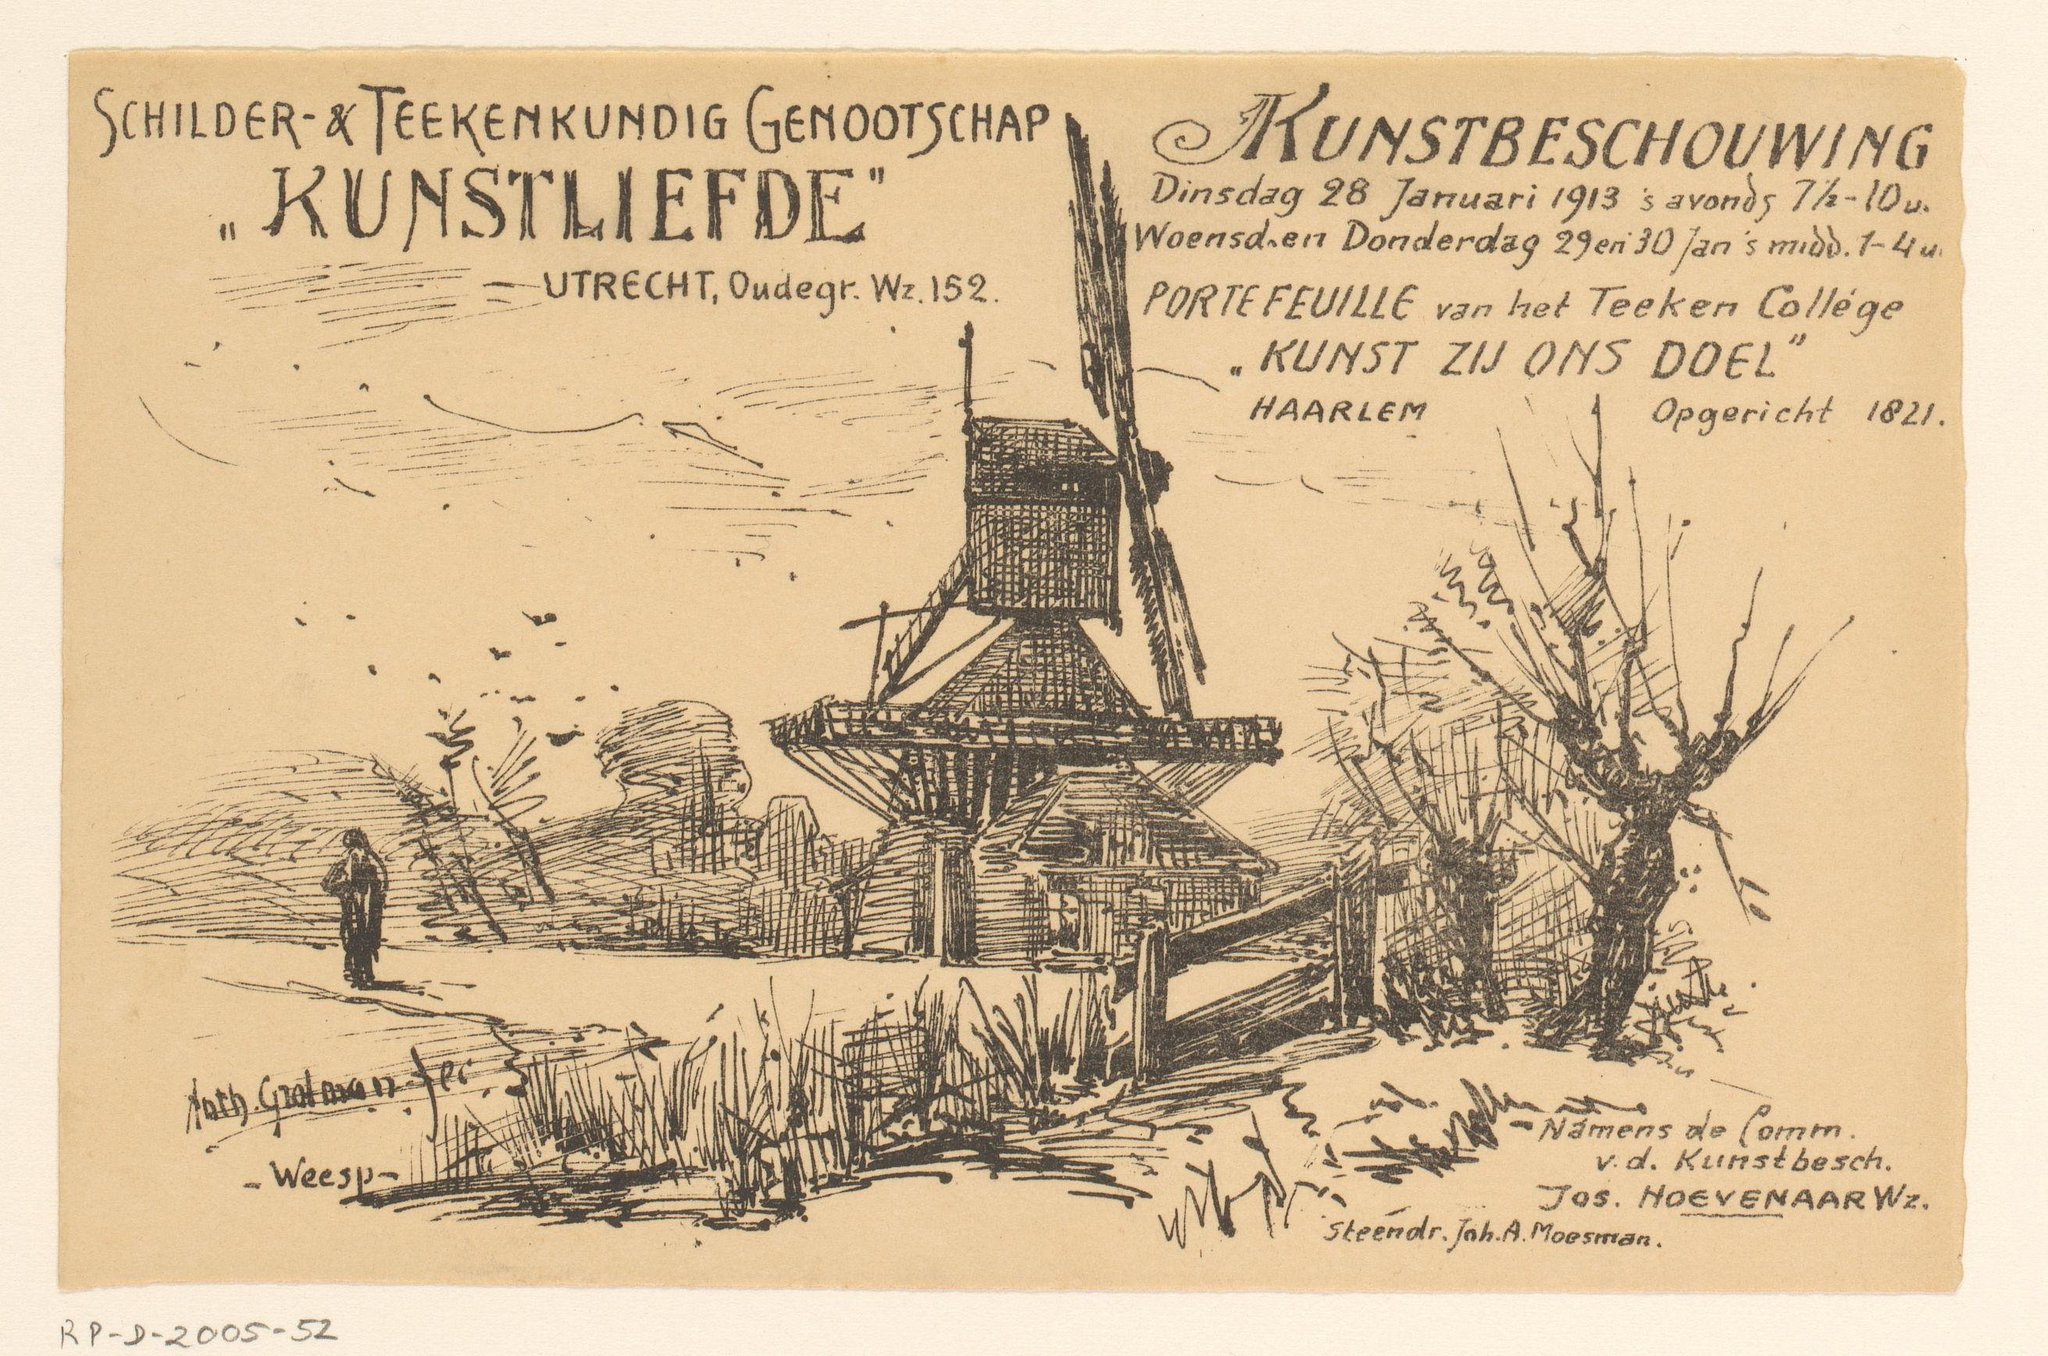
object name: invitation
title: Uitnodiging van Schilder- en Teekenkundig Genootschap "Kunstliefde" voor een kunstbeschouwing, 28-30 januari 1913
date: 1901-1913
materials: paper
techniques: lithograph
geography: utrecht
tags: criticizing and discussing art, art criticism, circle, club of artists, collecting and exhibiting products of the fine arts, windmill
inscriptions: collector's mark: Lugt 2228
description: Windmolen te Weesp. Uitnodiging van Schilder- en Teekenkundig Genootschap "Kunstliefde" voor een kunstbeschouwing op 28-30 januari 1913 van de portefeuille van het 'Teeken College "Kunst zij ons Doel" te Haarlem'.